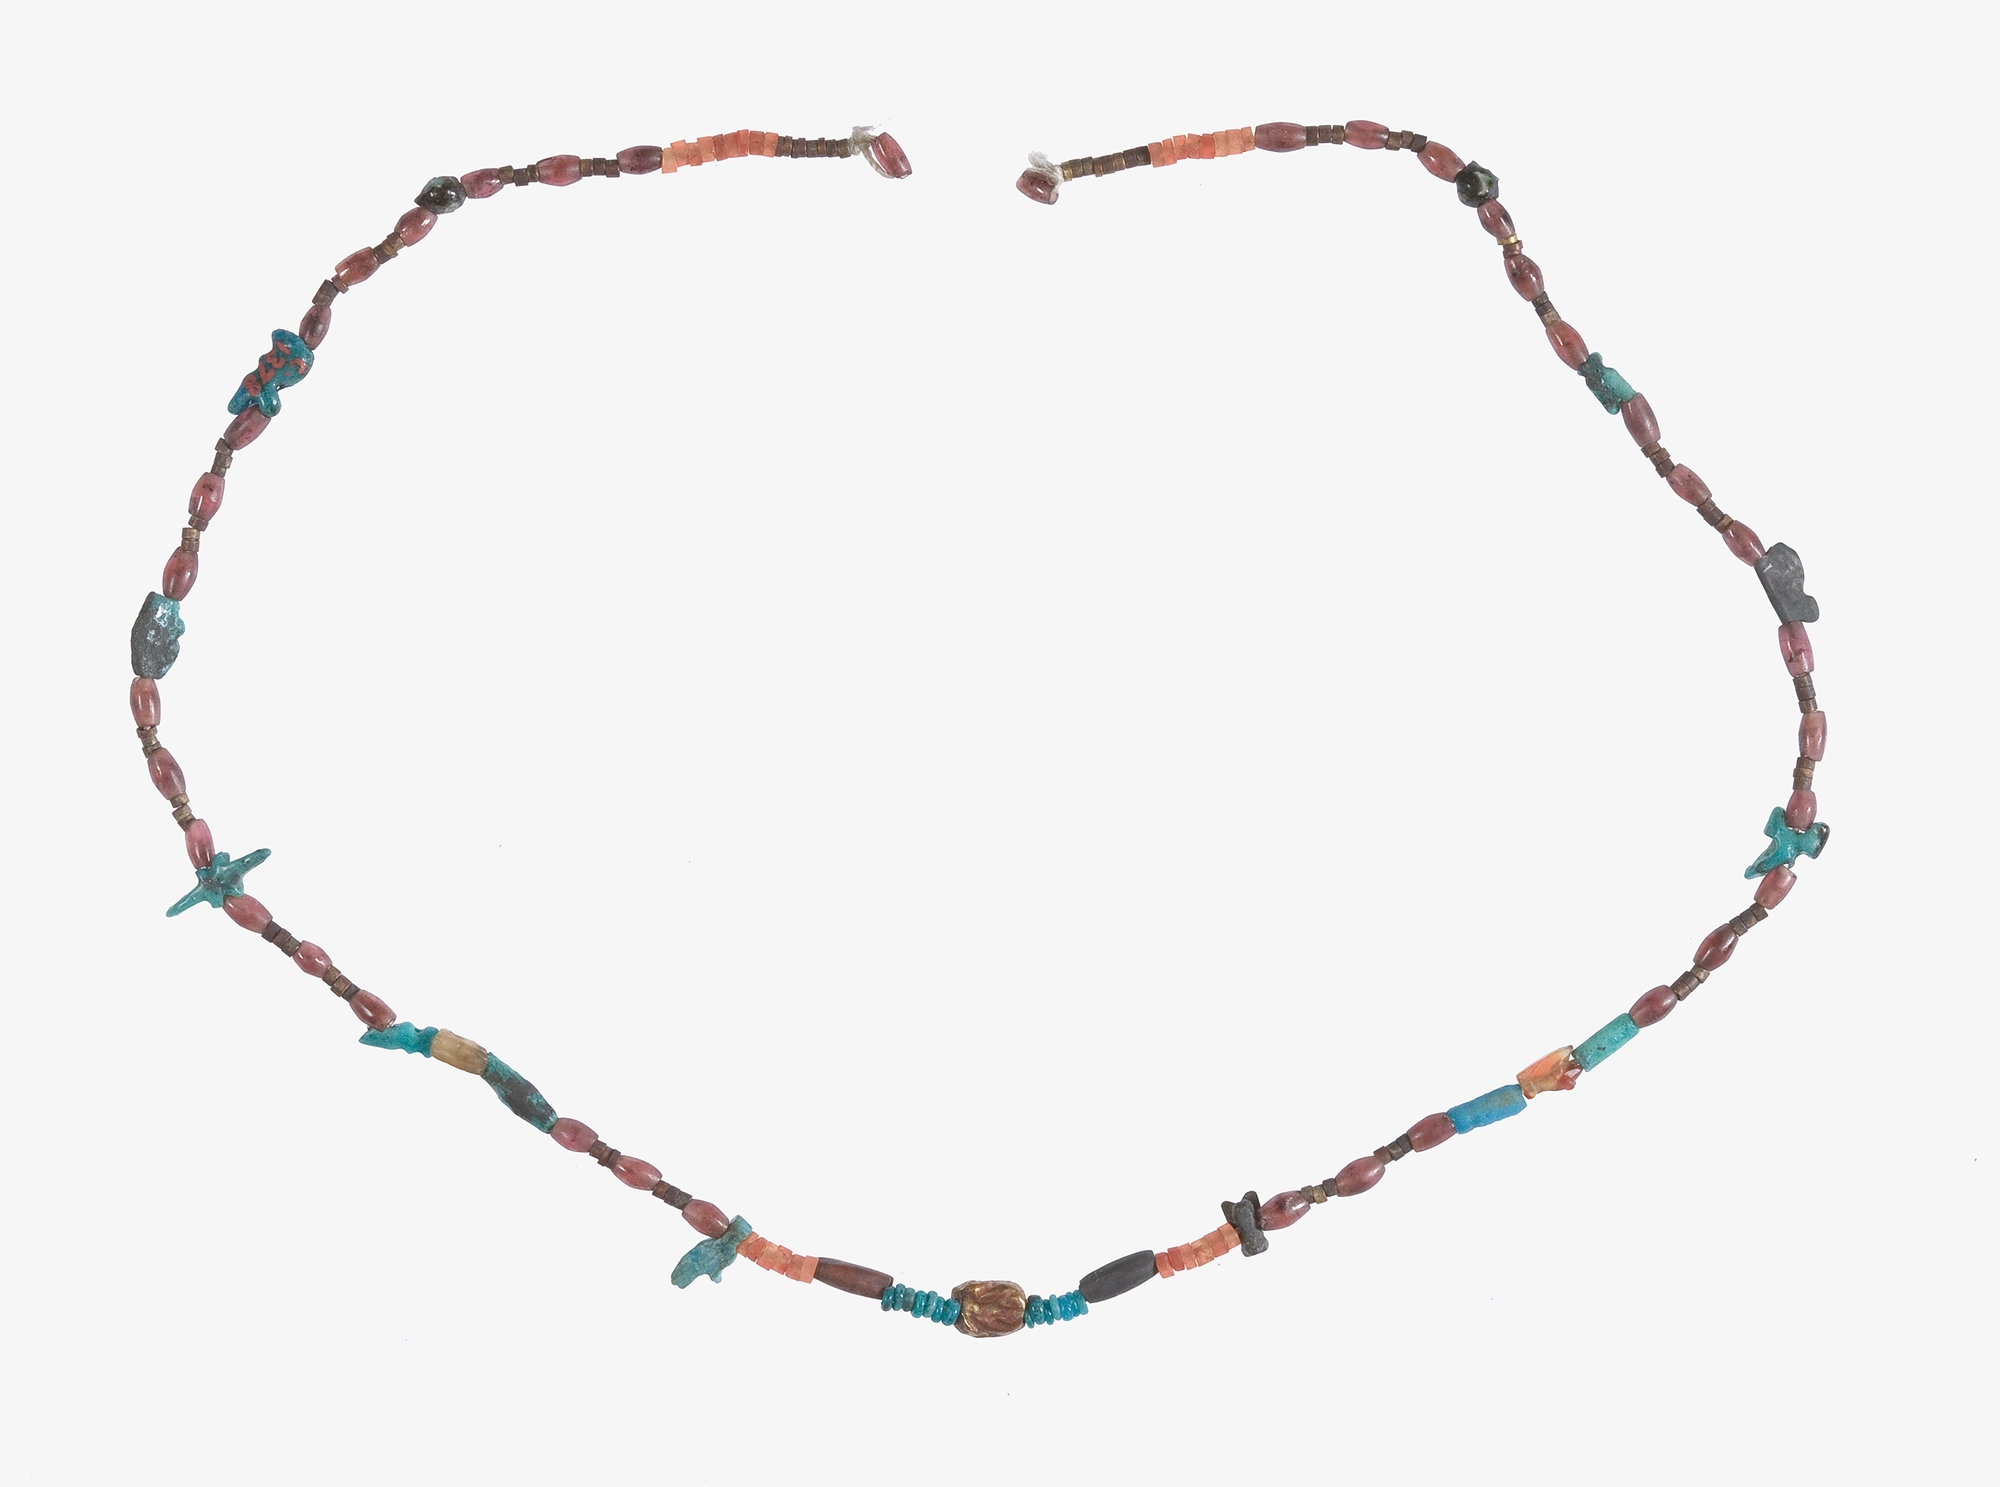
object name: necklace, bead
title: Necklace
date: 1991-1450 BCE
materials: gemstone, faience, gold, silver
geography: egypt